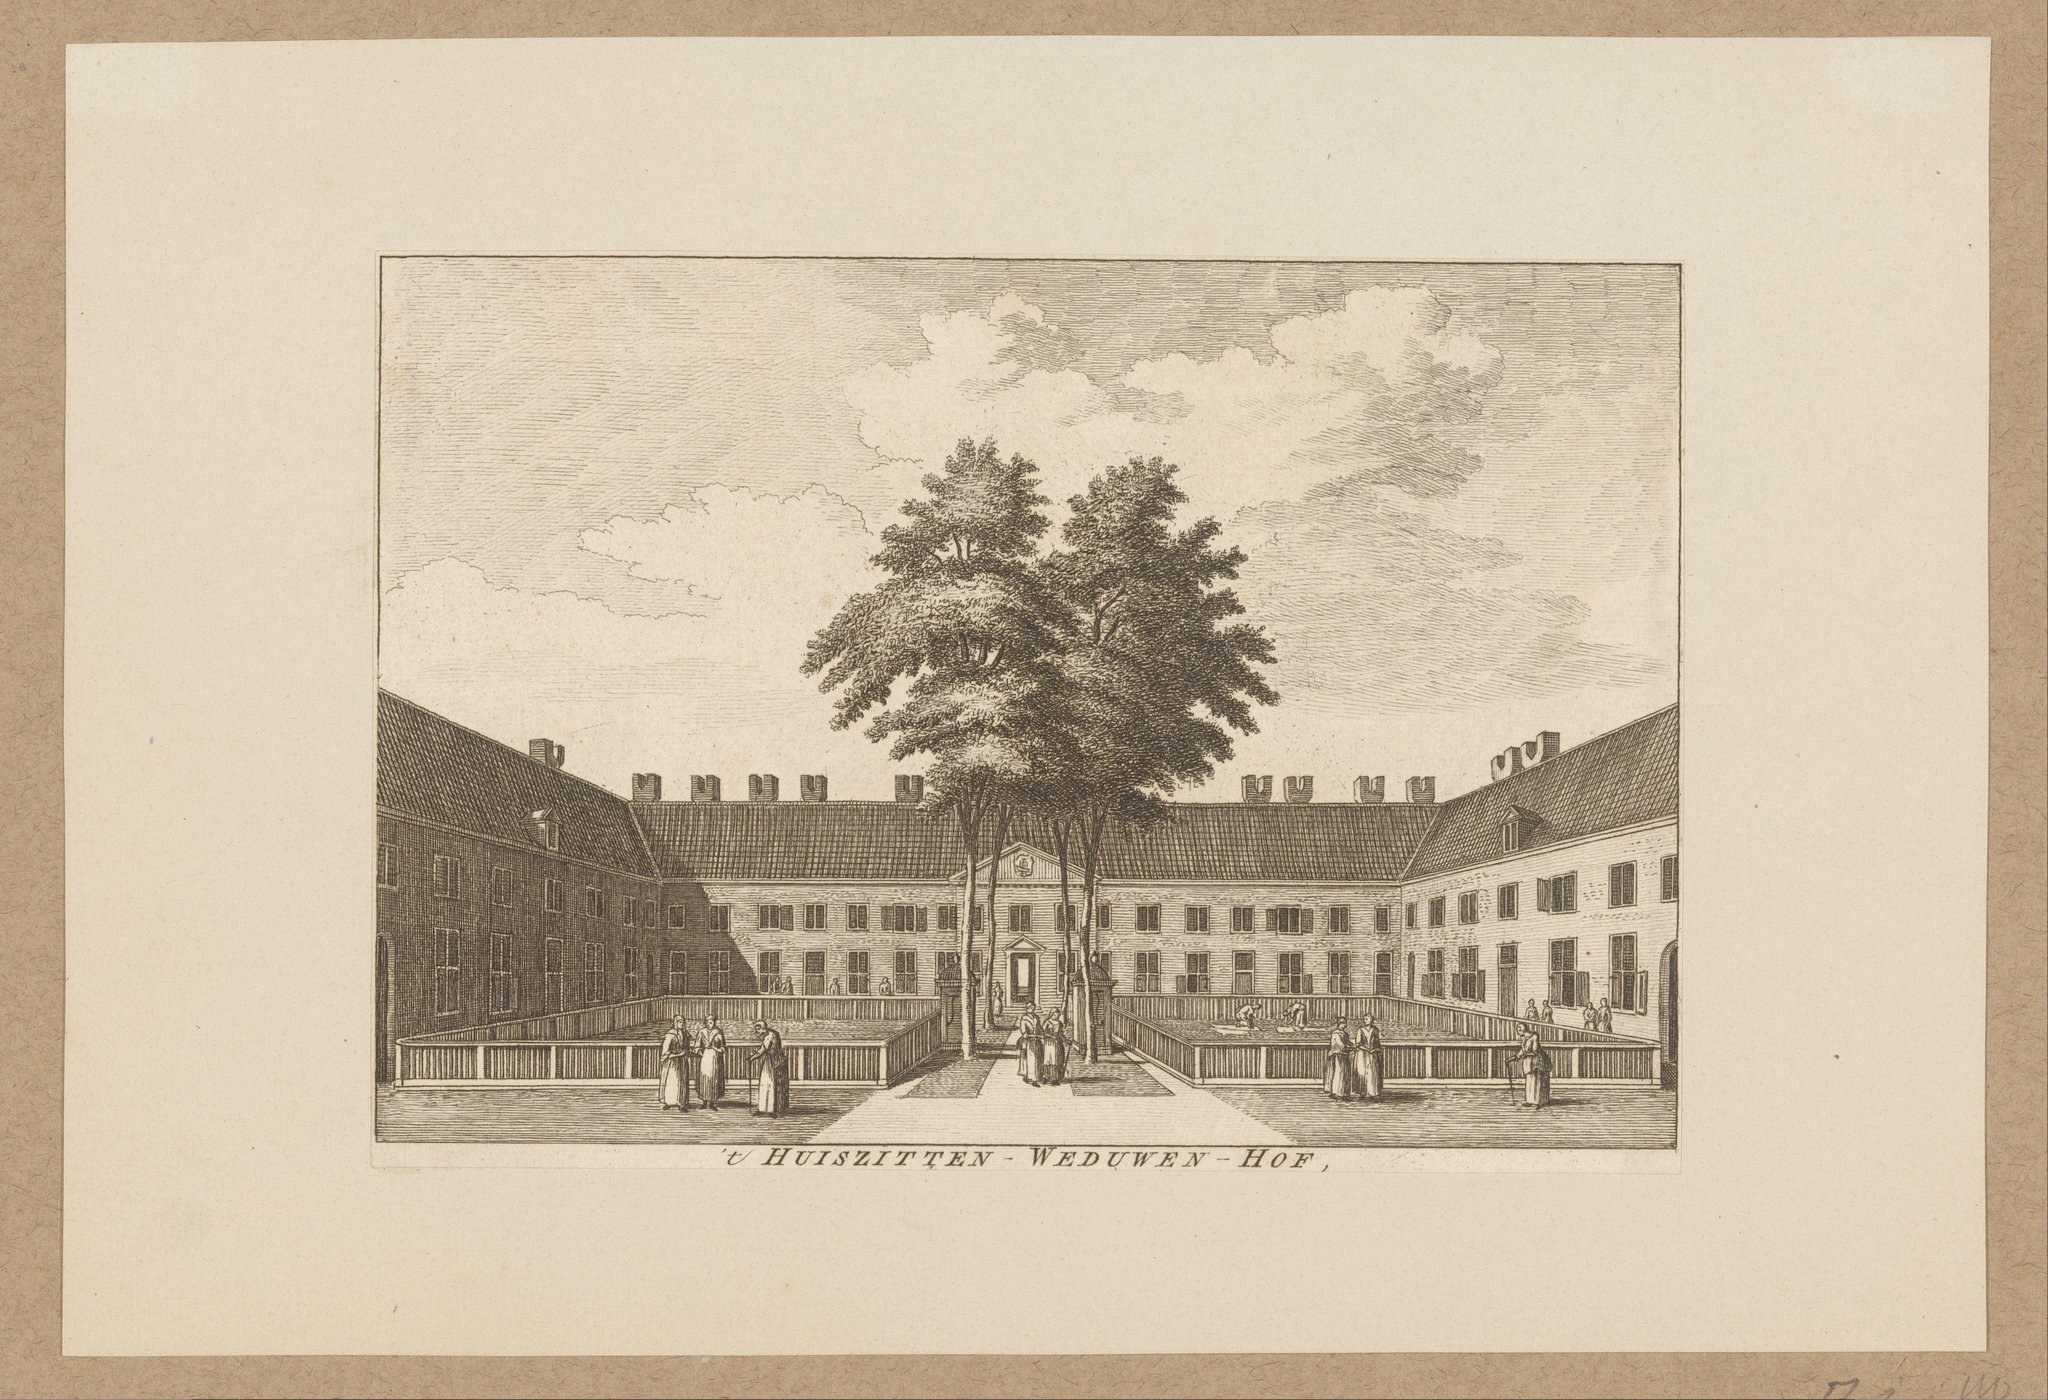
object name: print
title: 't Huiszitten-Weduwen-Hof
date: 1765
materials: paper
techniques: etching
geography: amsterdam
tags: alms-house (dutch: 'hofje'), courtyard, old-people's home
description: Prent uit: Wagenaar, Jan. Amsterdam, in zyne opkomst, aanwas, geschiedenissen (…). Amsterdam: Isaak Tirion, 1765, dl. 2, tussen p. 270 en 271.